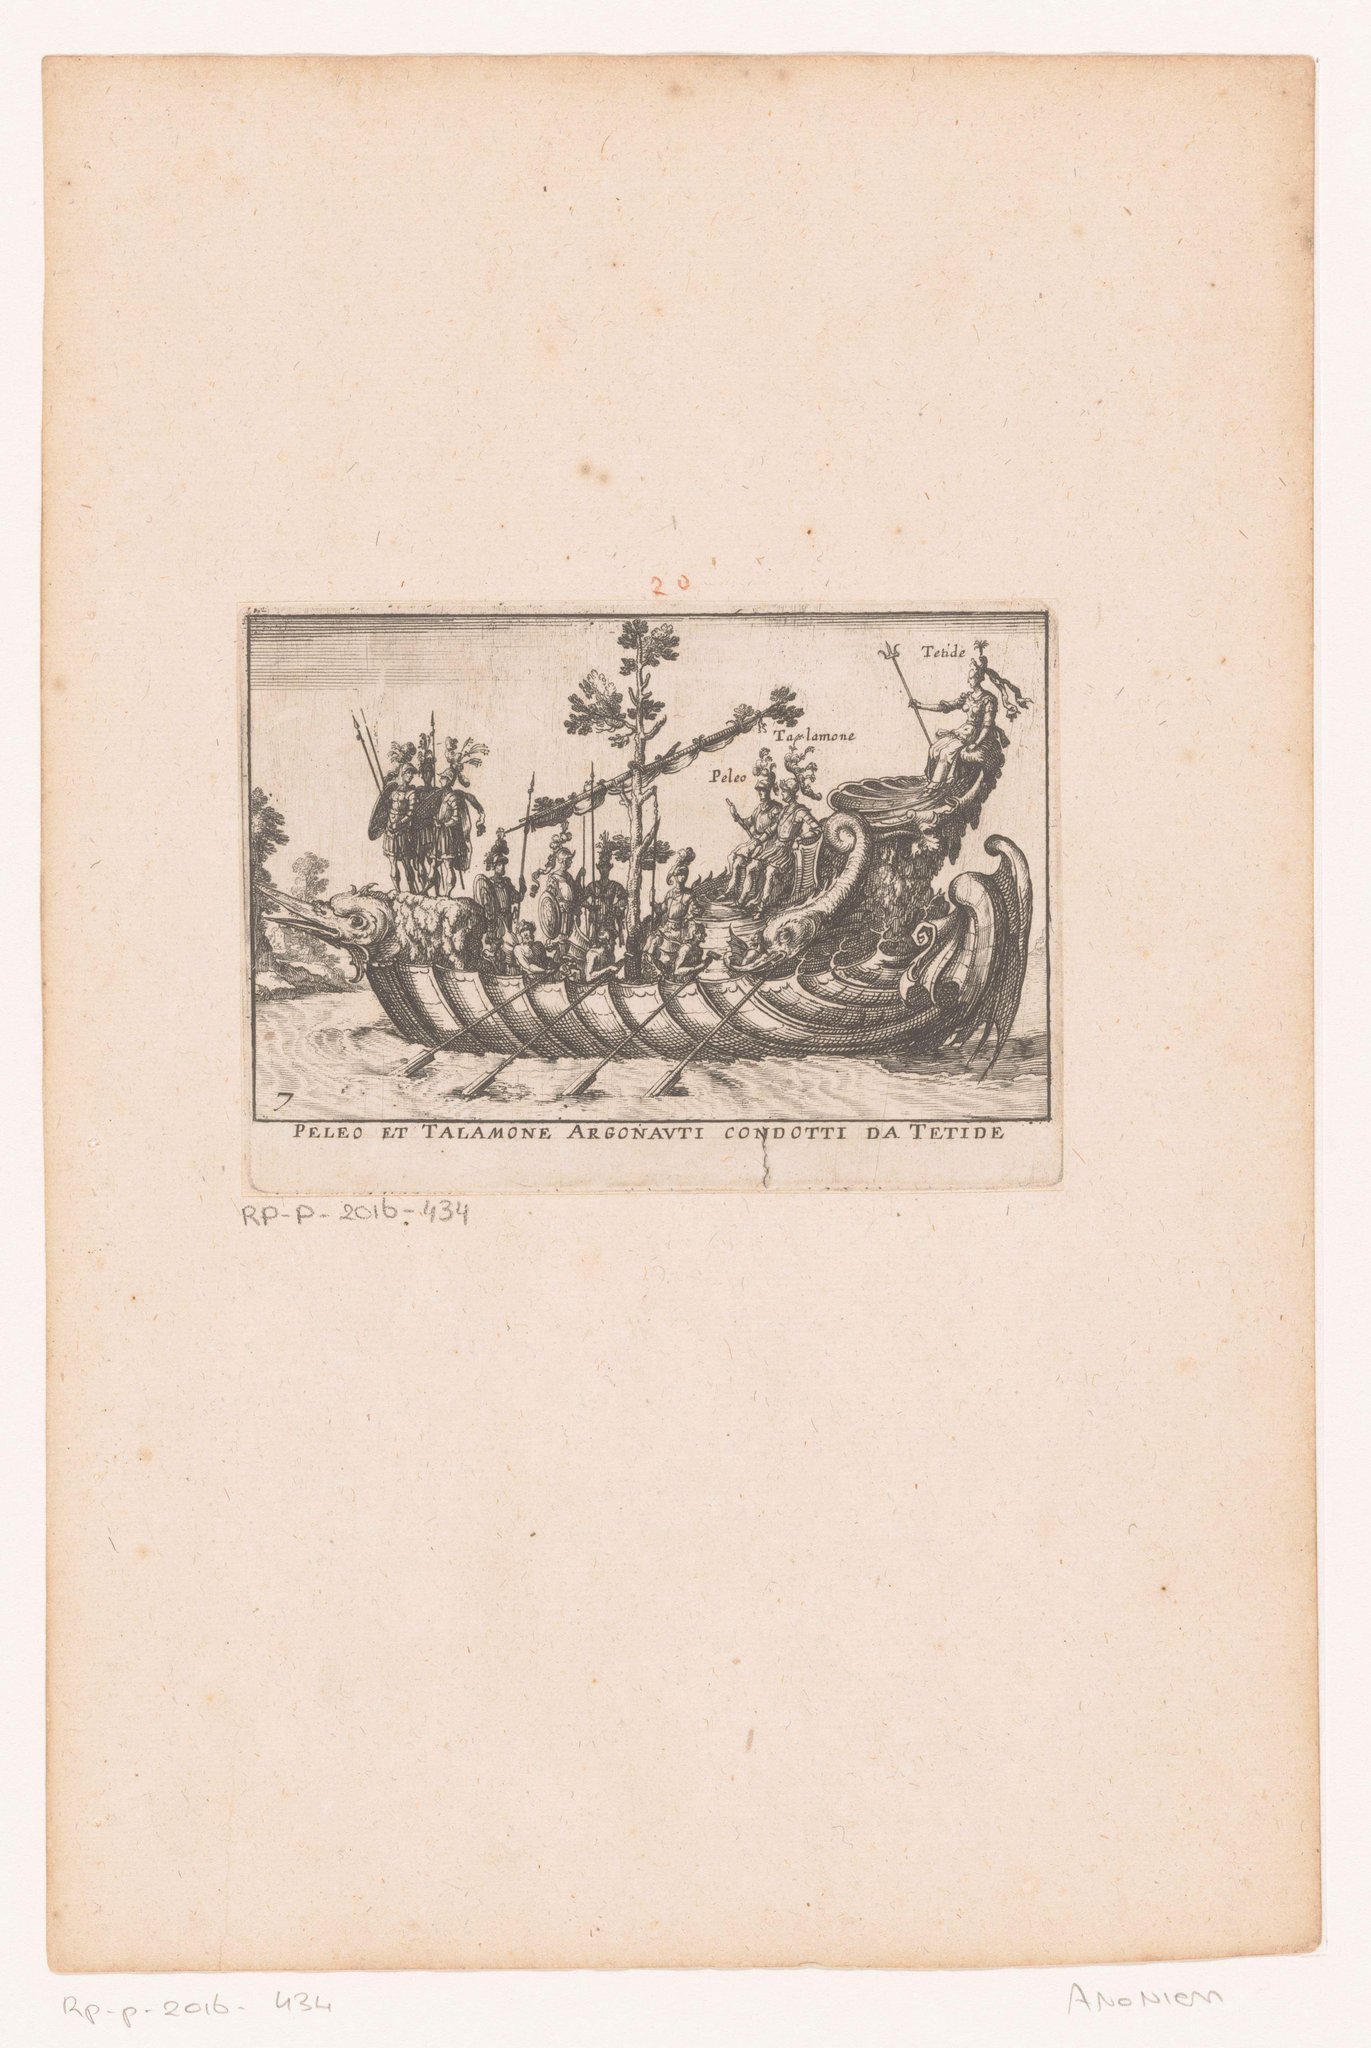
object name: print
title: Argonautenschepen voor de strijd op de Arno tijdens het huwelijksfeest van Cosimo II de' Medici te Florence in 1608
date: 1624-1631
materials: paper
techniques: etching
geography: paris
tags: ships (in general), the story of the argonauts: the quest for the golden fleece, (story of) peleus and thetis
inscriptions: collector's mark: Lugt 2228, number: ‘20’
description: Een schip met vogelkop als boeg en een boom als mast. Op het achtersteven zitten Peleus, Telamon en Thetis.